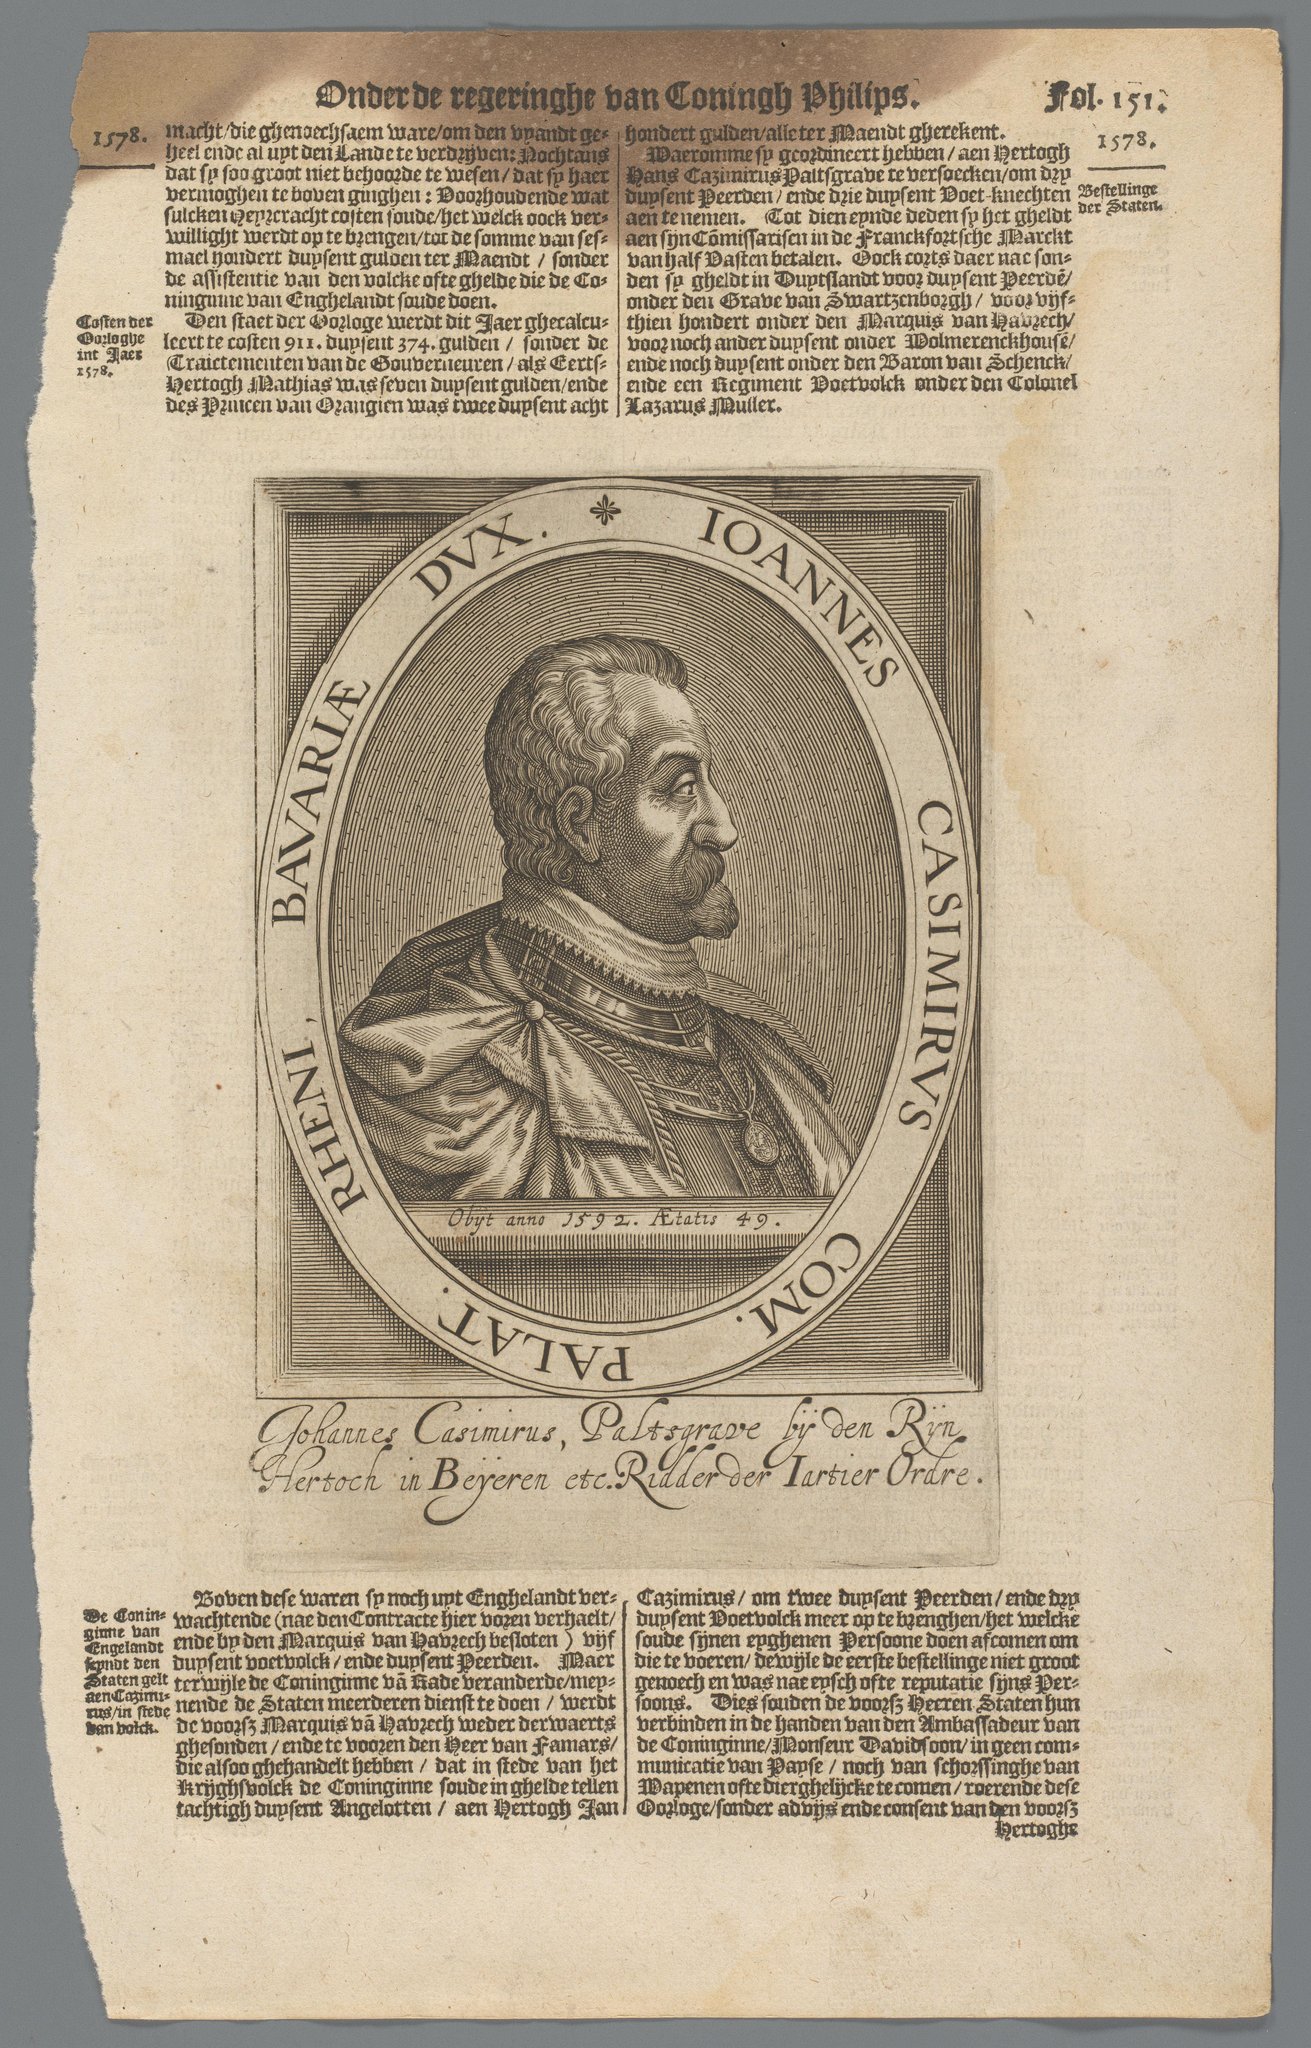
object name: print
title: Portret van Johan Casimir van Palts-Lautern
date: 1614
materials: paper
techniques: engraving, letterpress printing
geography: the hague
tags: historical persons, ruler, sovereign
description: Prent uit: Meteren, Emanuel van. Historie der Nederlandscher ende haerder na-buren oorlogen ende geschiedenissen (...). Den Haag: Hillebrant Iacobsz. van Wouw, 1614.